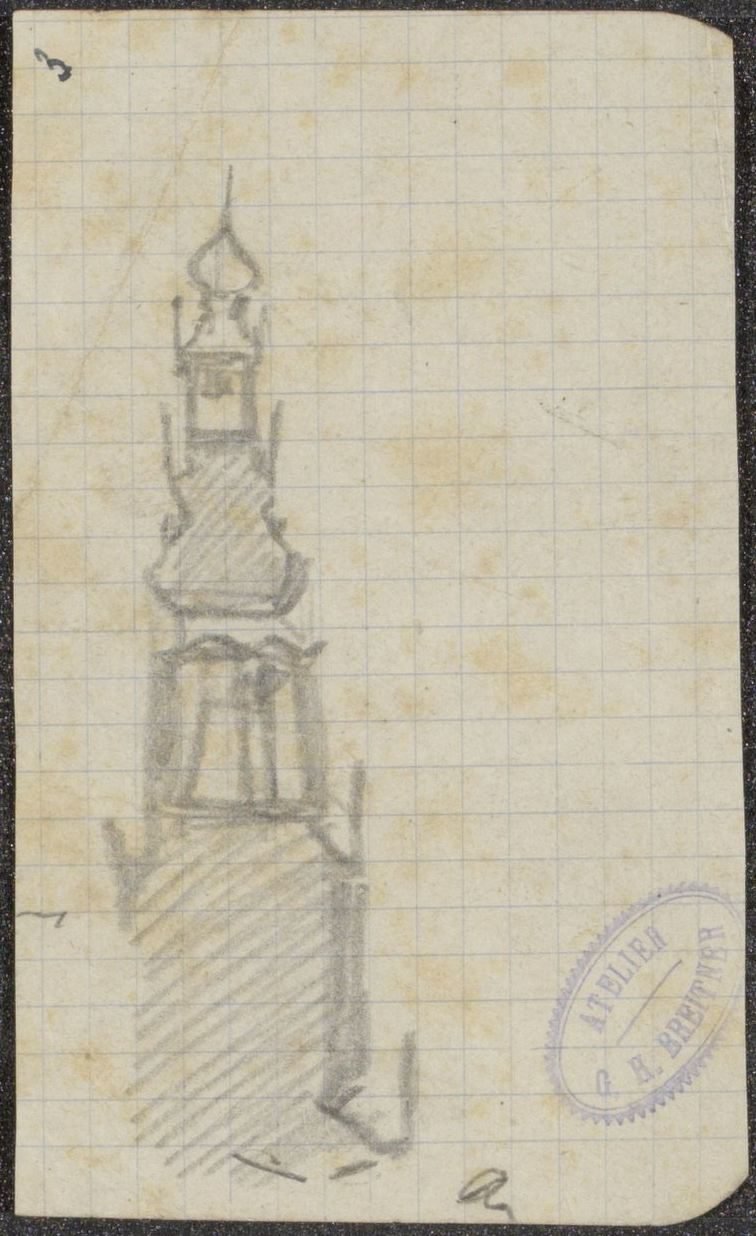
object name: drawing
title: Toren van de Oude Kerk te Amsterdam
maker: george hendrik breitner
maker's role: draughtsman, painter, print maker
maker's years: 1857-1923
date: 1886-1923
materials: pencil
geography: amsterdam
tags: parts of church exterior and annexes: tower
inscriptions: workshop stamp: Lugt 291d